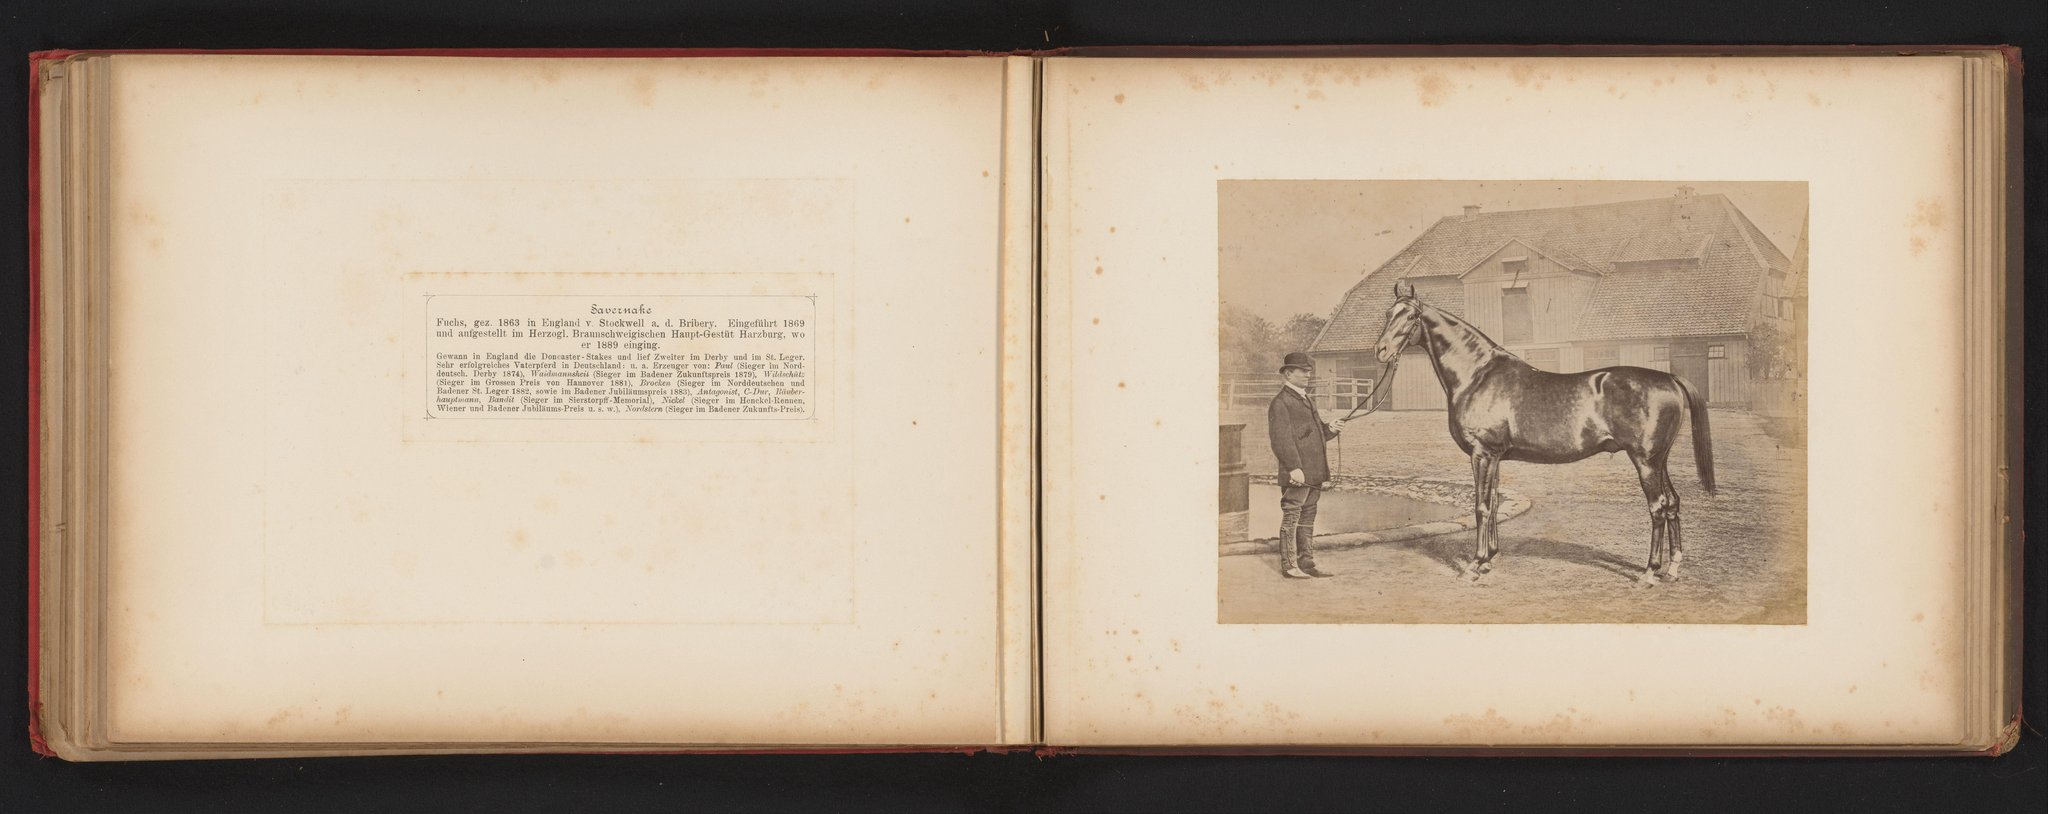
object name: page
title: Man met paard, genaamd Savernake, voor een boerderij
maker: h. schnaebeli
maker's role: fotograaf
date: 1894-1915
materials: photographic support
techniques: albumen print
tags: adult man, historical persons, horse